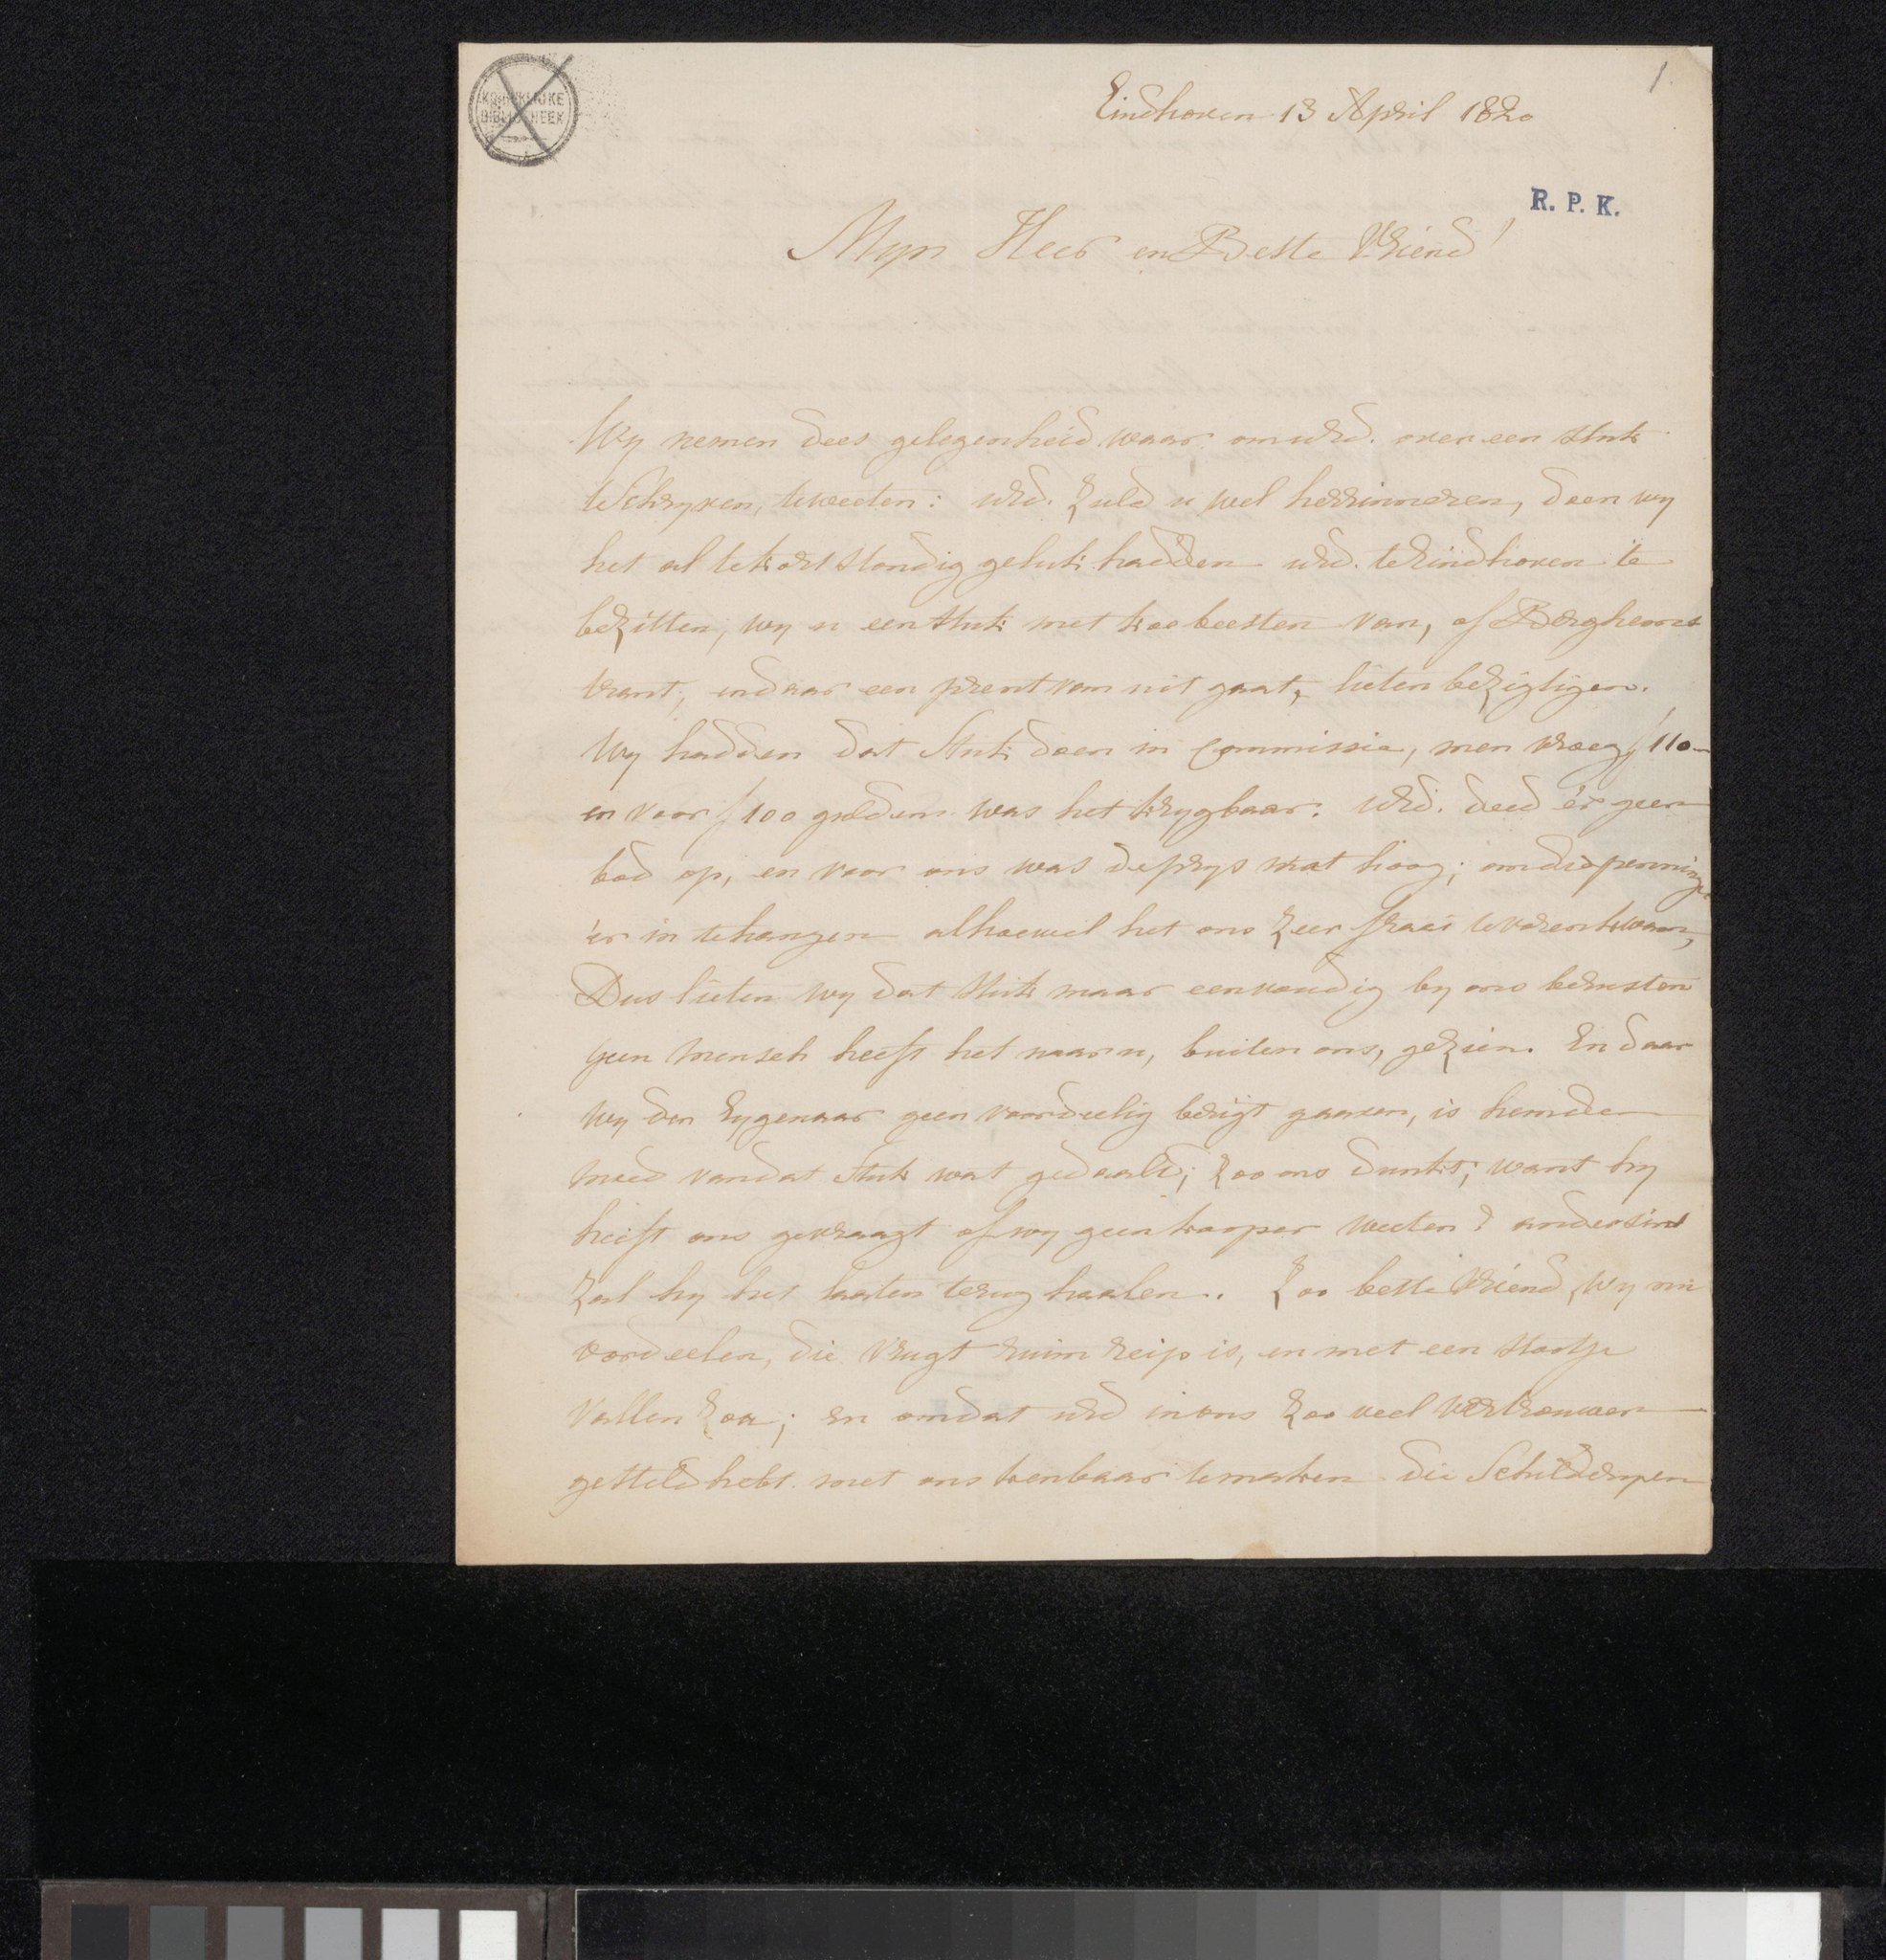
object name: letter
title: Brief aan Ernst Willem Jan Bagelaar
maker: antonis aloisius emanuel van bedaff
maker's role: print maker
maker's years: 1787-1829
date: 1820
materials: ink, paper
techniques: pen, writing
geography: eindhoven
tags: draughtsman, ernst willem jan bagelaar, art trade, art shop, the graphic arts, painting (including book-illumination, miniature-painting), money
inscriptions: collector's mark: Lugt 2233